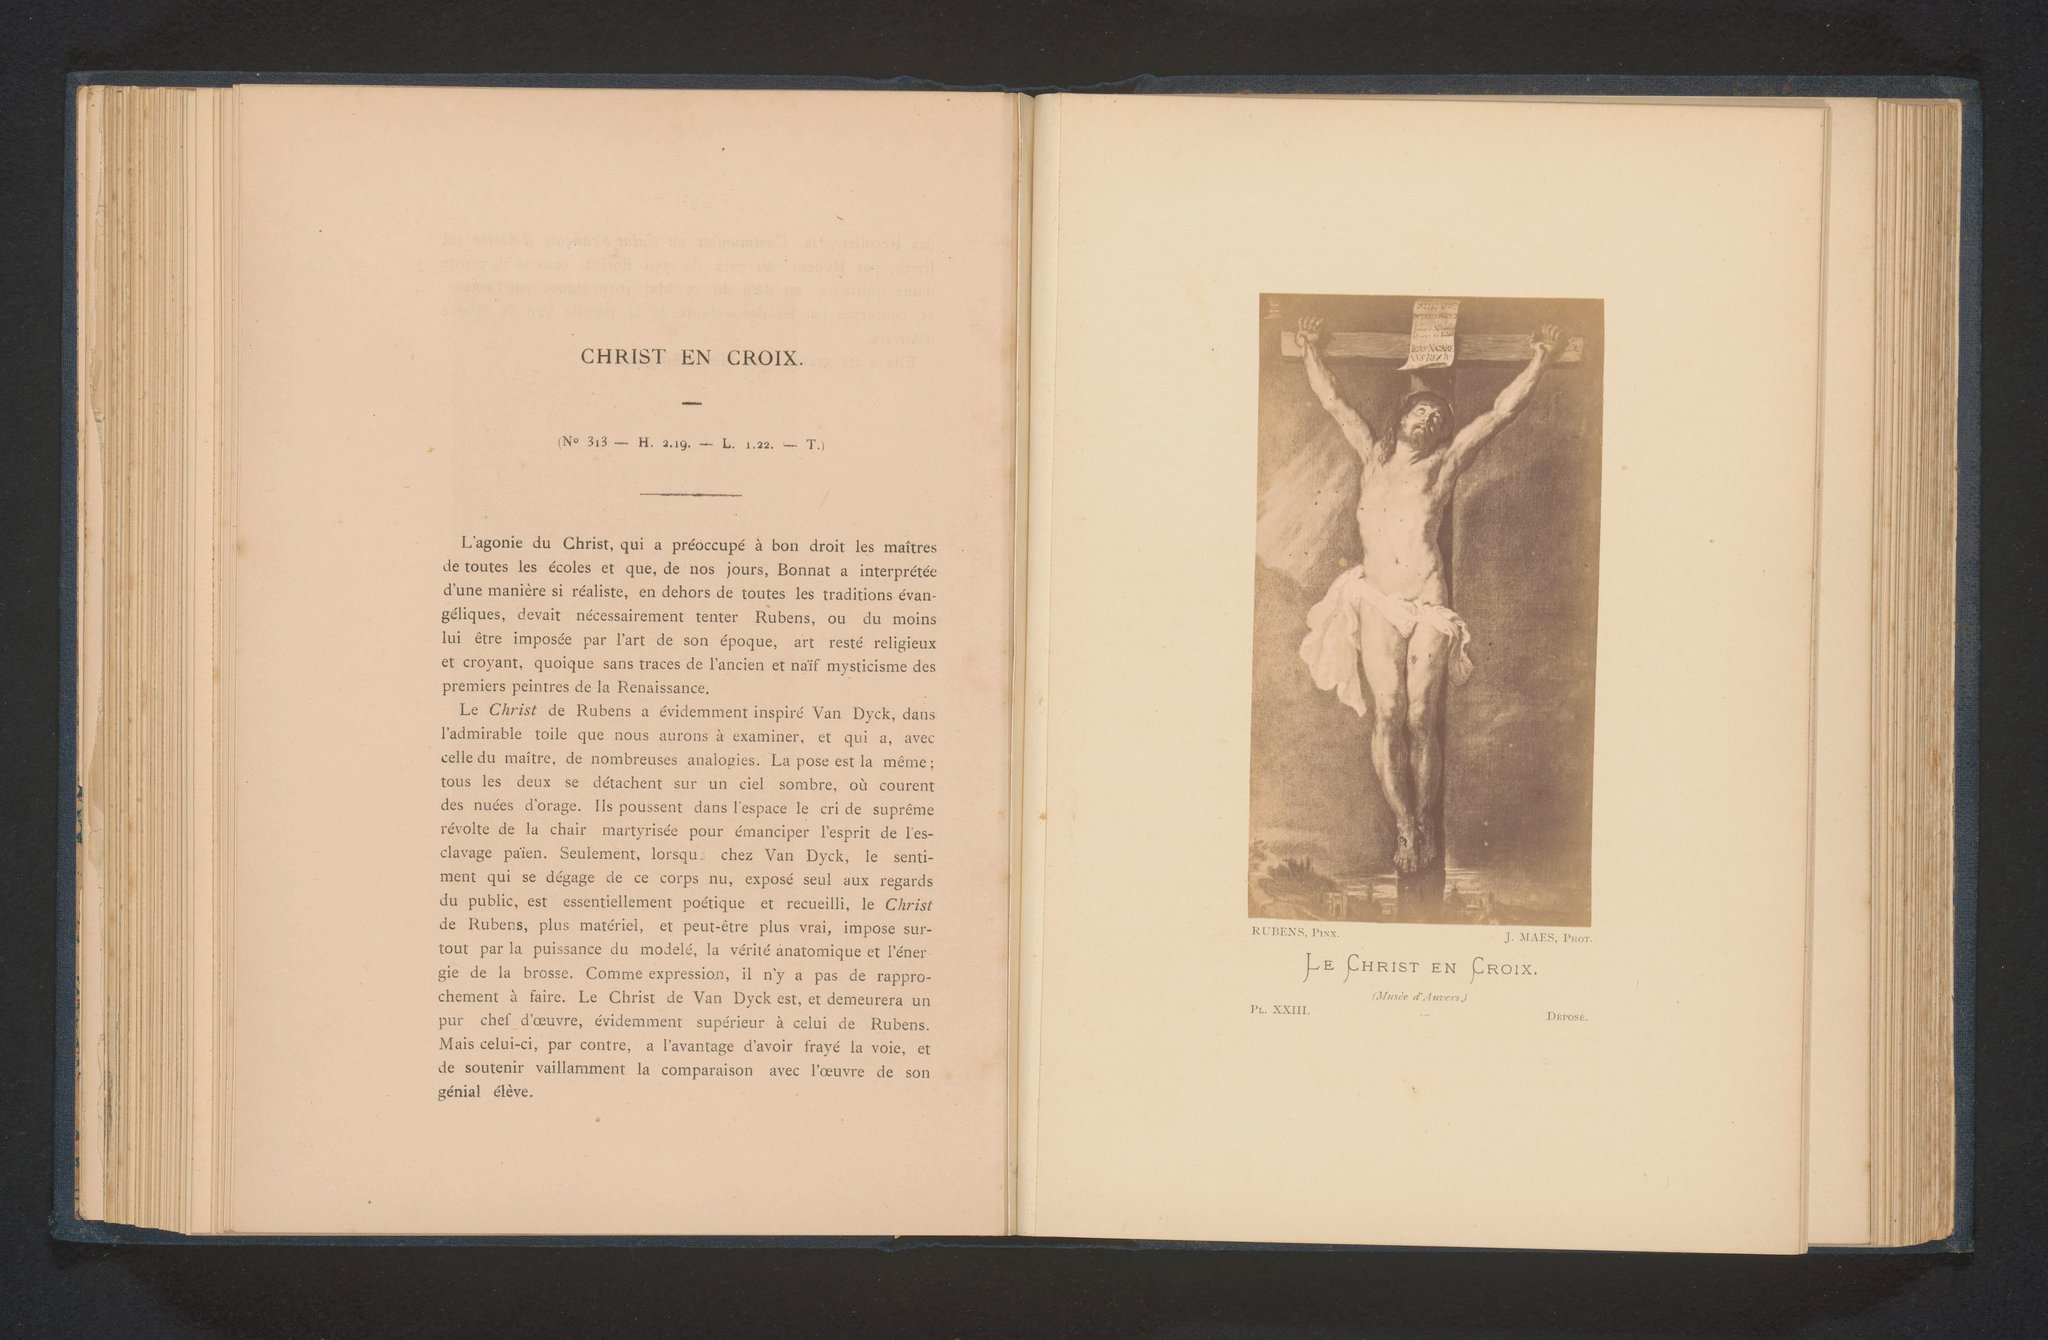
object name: photograph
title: Le Christ en Croix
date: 1872-1877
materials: photographic support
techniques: albumen print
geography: antwerp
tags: the crucifixion of christ: christ's death on the cross; golgotha (matthew 27:45-58; mark 15:33-45; luke 23:44-52; john 19:25-38)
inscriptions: inscription: ‘(Musée d'Anvers)/ Pl. XXIII. Déposé.’